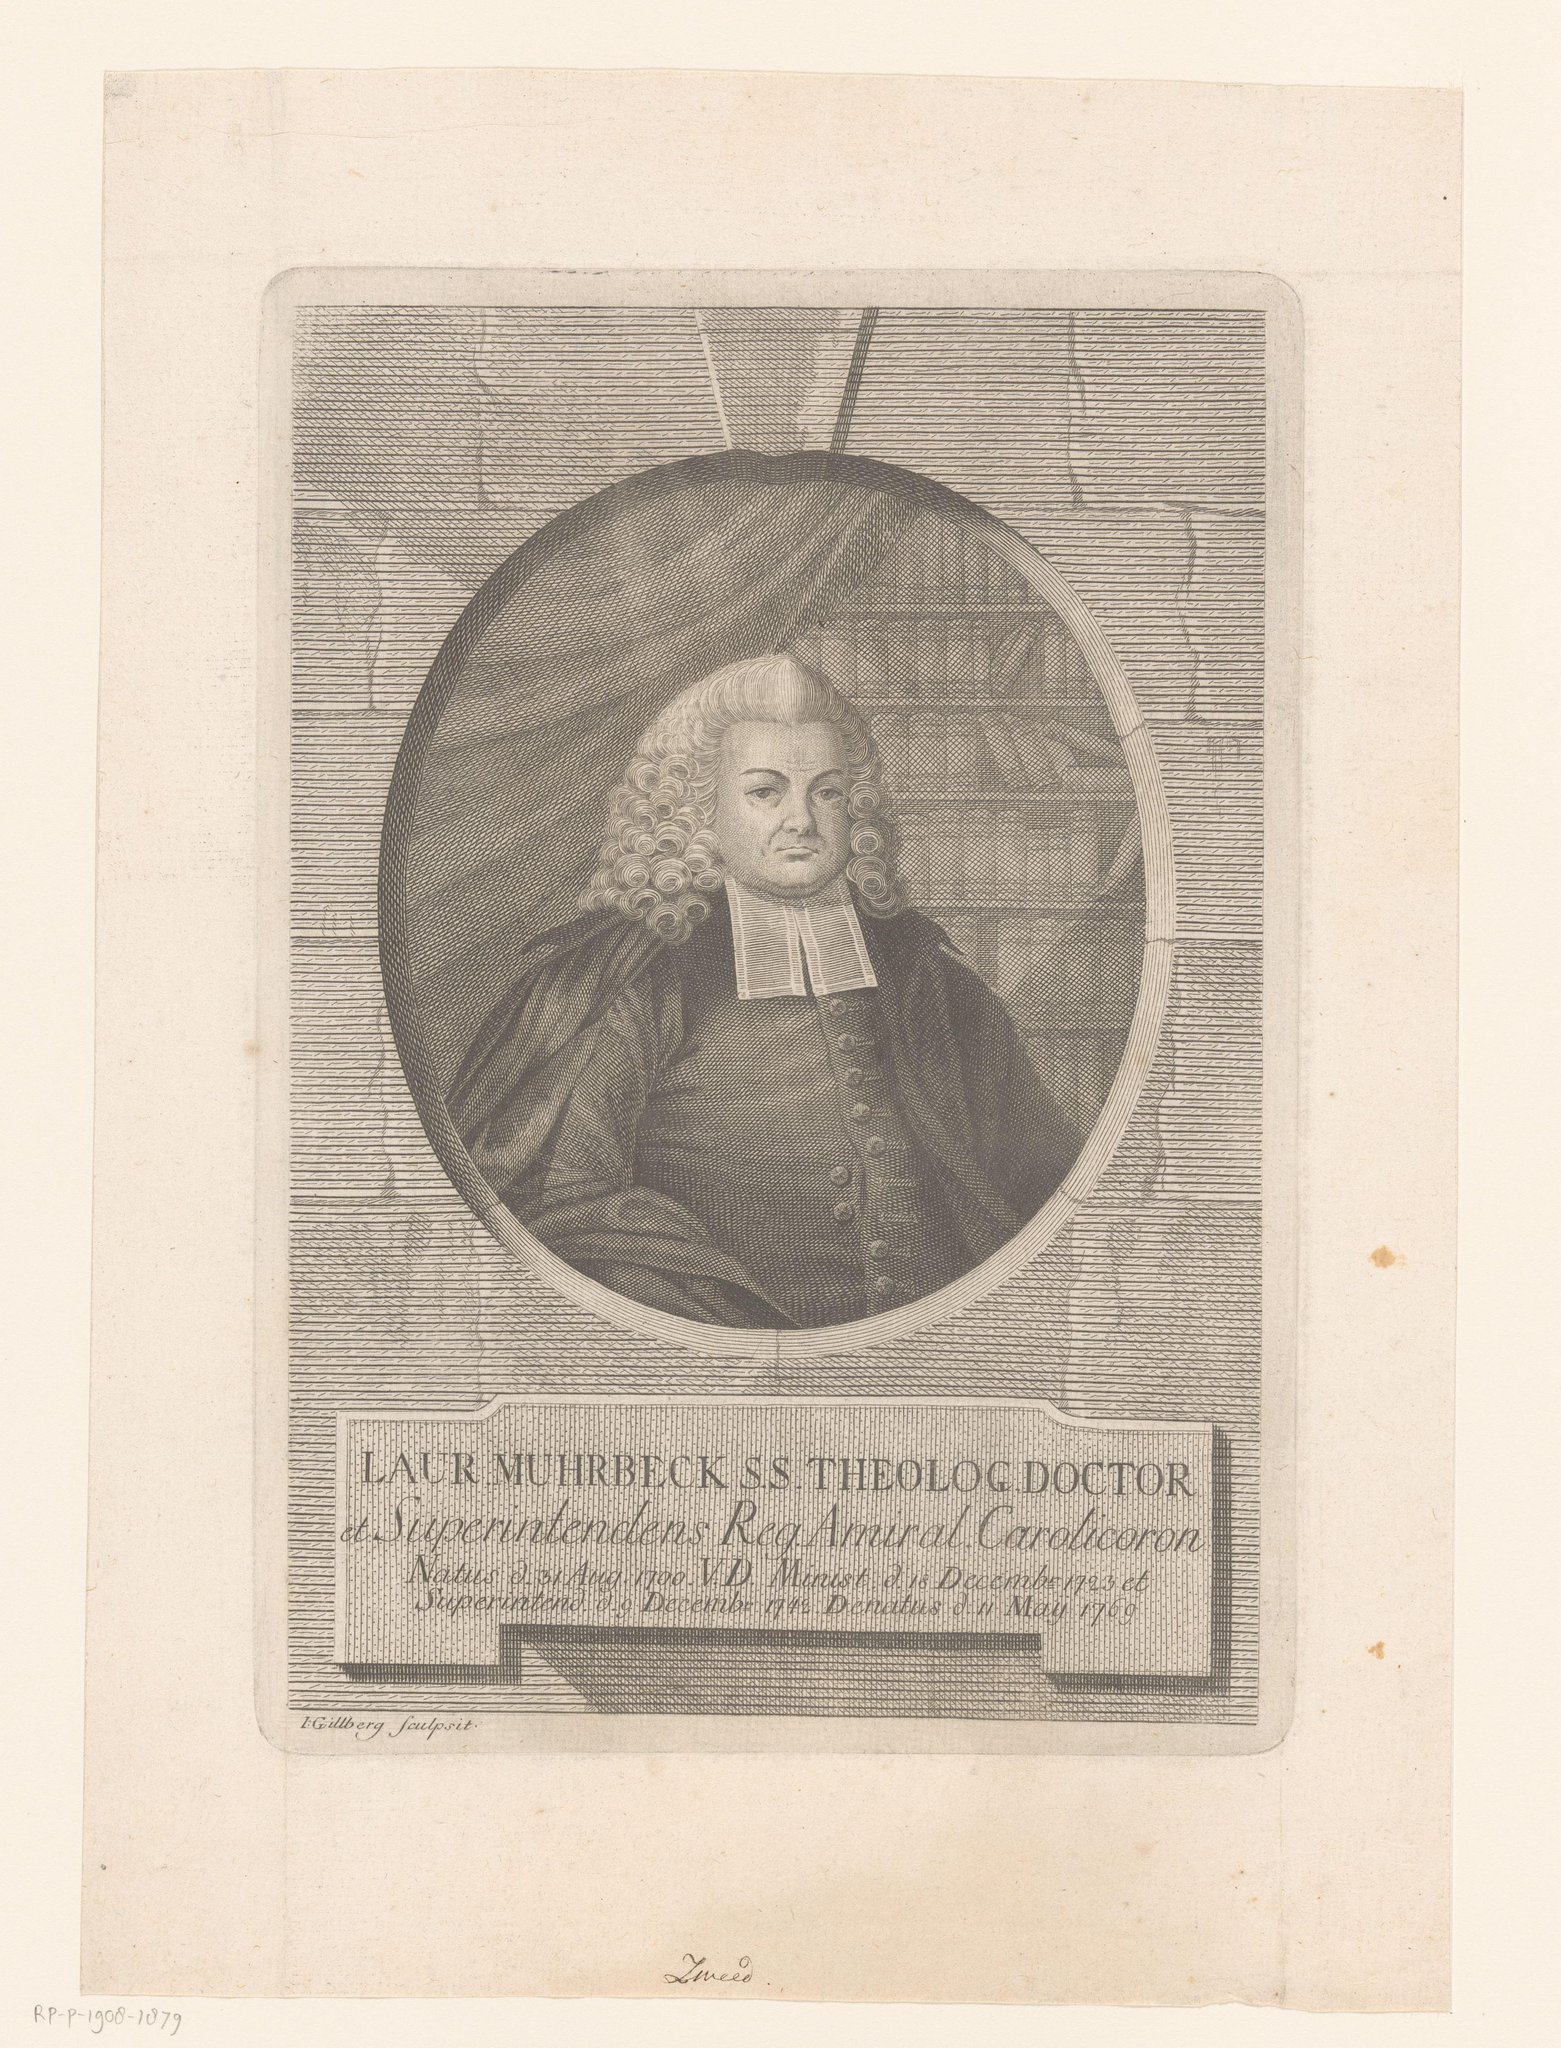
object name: print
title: Portret van Lorenz Muhrbeck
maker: jakob gillberg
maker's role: print maker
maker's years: 1724-1793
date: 1769-1793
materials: paper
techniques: engraving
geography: sweden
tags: historical persons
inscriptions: collector's mark: Lugt 2228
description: Portret van Lorenz Muhrbeck, Zweeds magistraat, ten halven lijve in ovaal naar rechts.